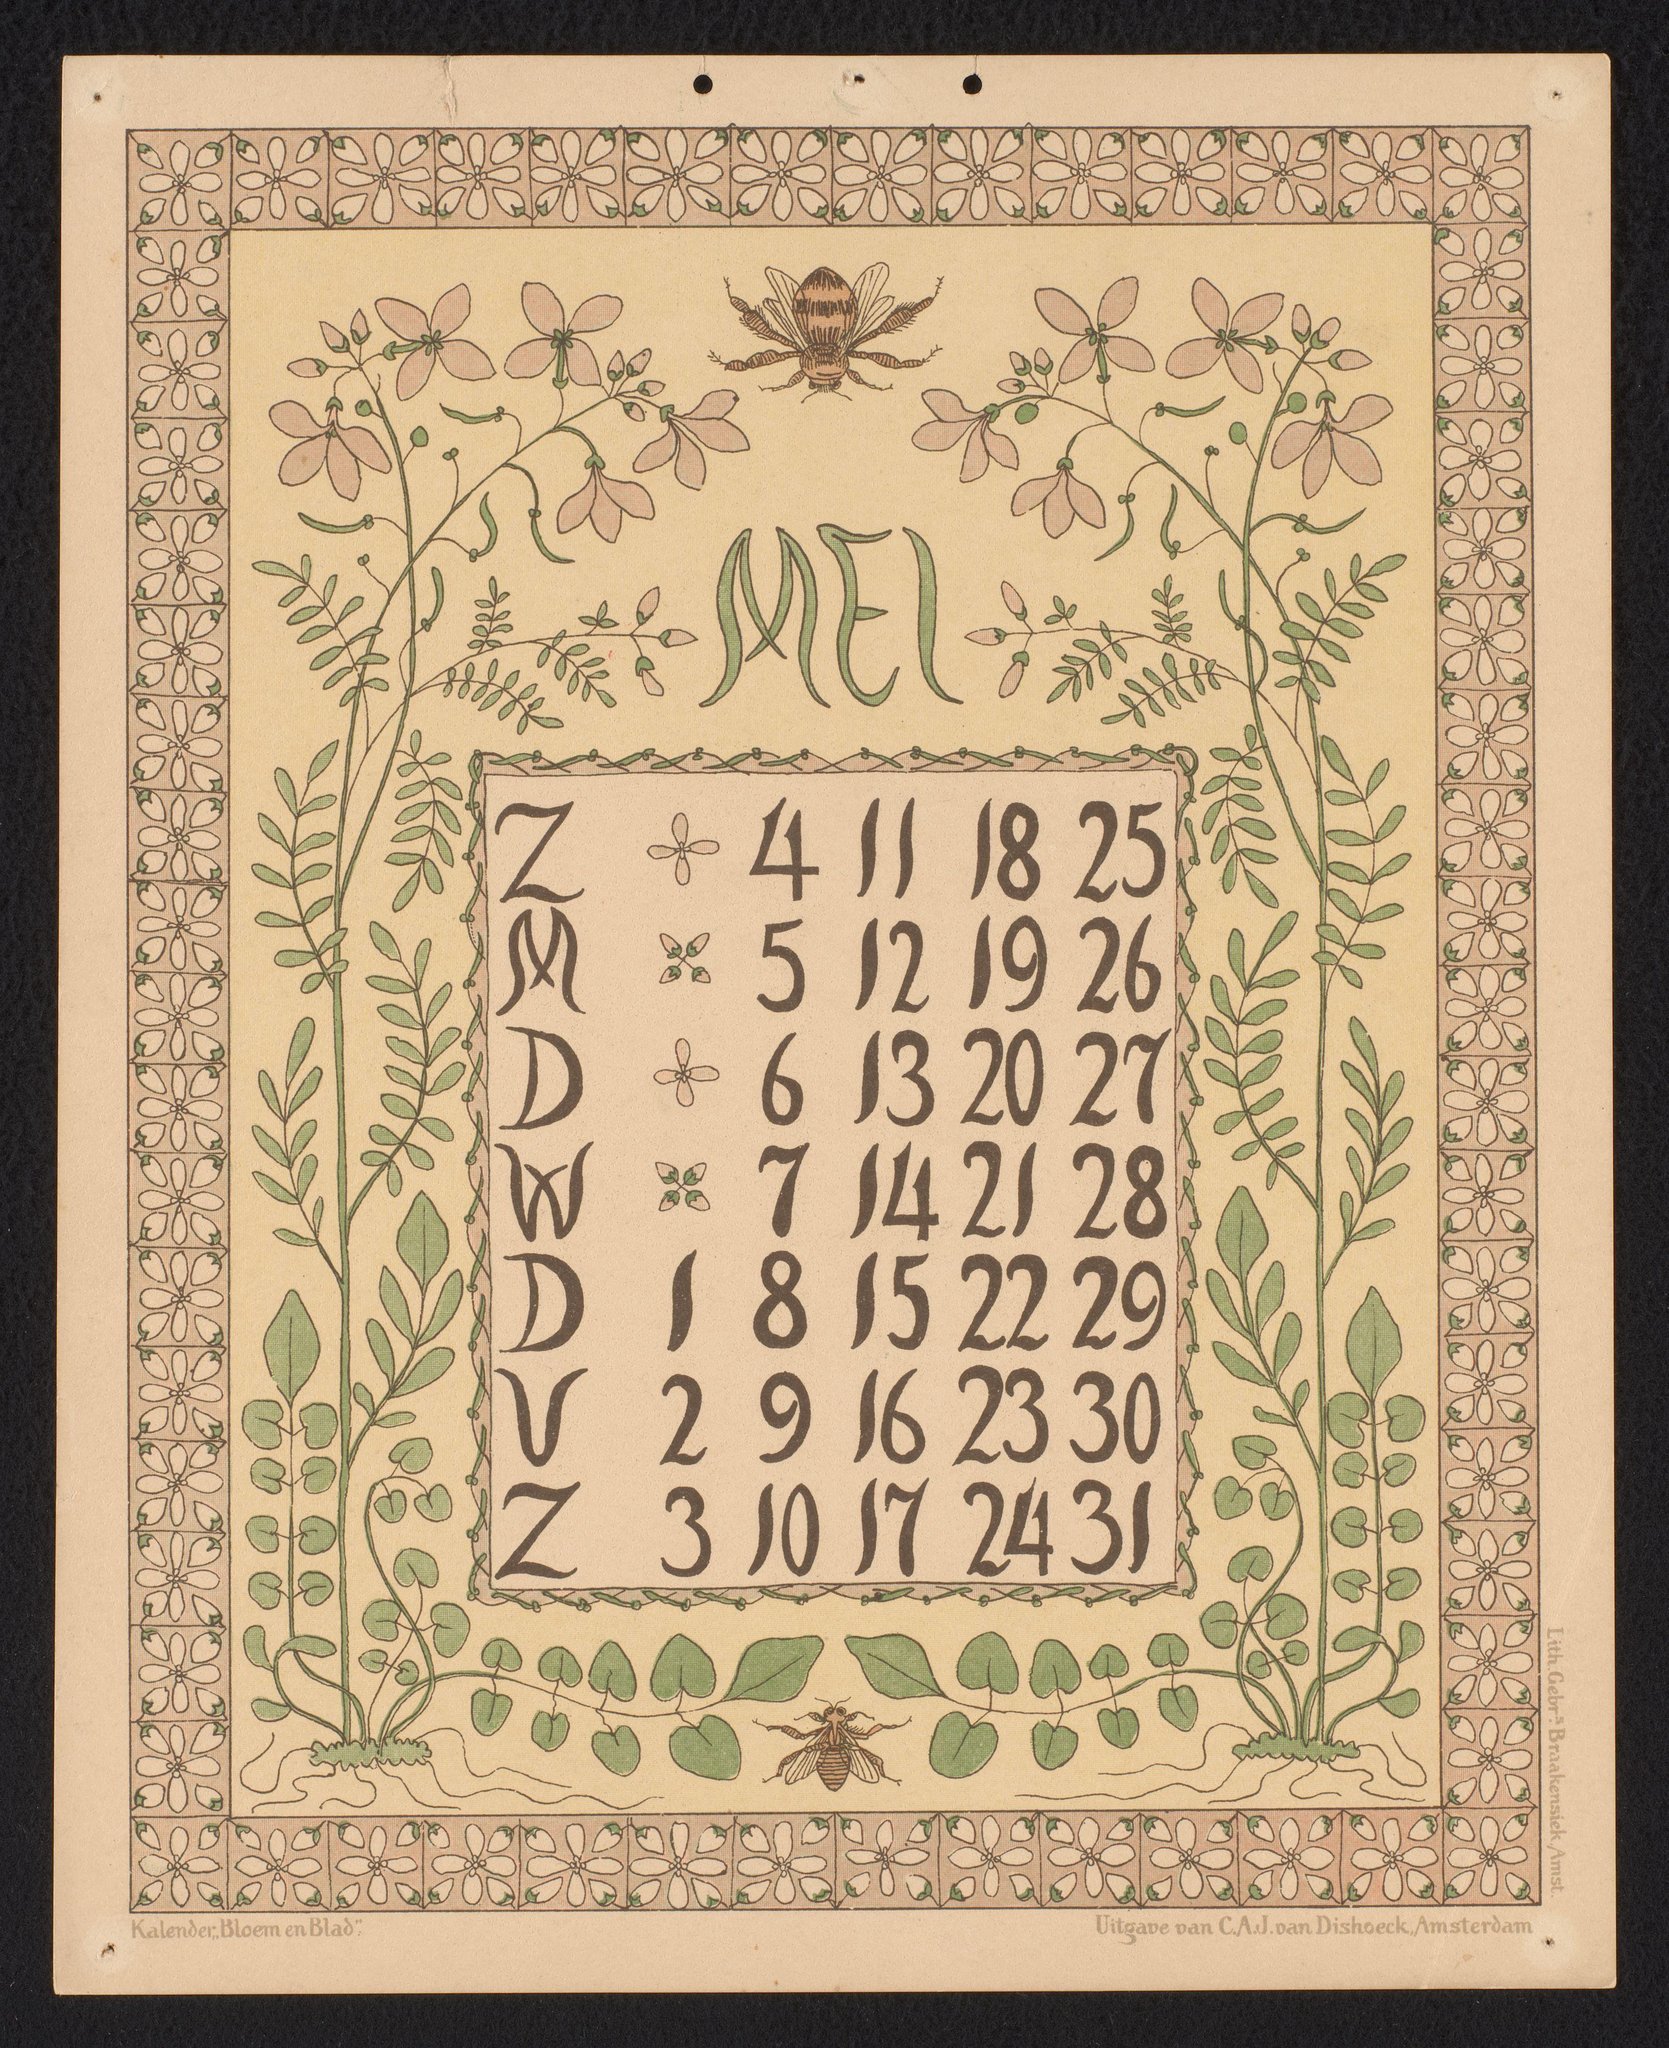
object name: calendar leaf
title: Kalenderblad voor mei 1902 met bloemen en hommels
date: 1901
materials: paper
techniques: lithograph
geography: amsterdam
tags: flowers, calendar, almanac, insects: bumblebee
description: Decoratieve rand van bloemen en twee hommels rond de maandkalender voor mei. Kalender 'Bloem en Blad'.